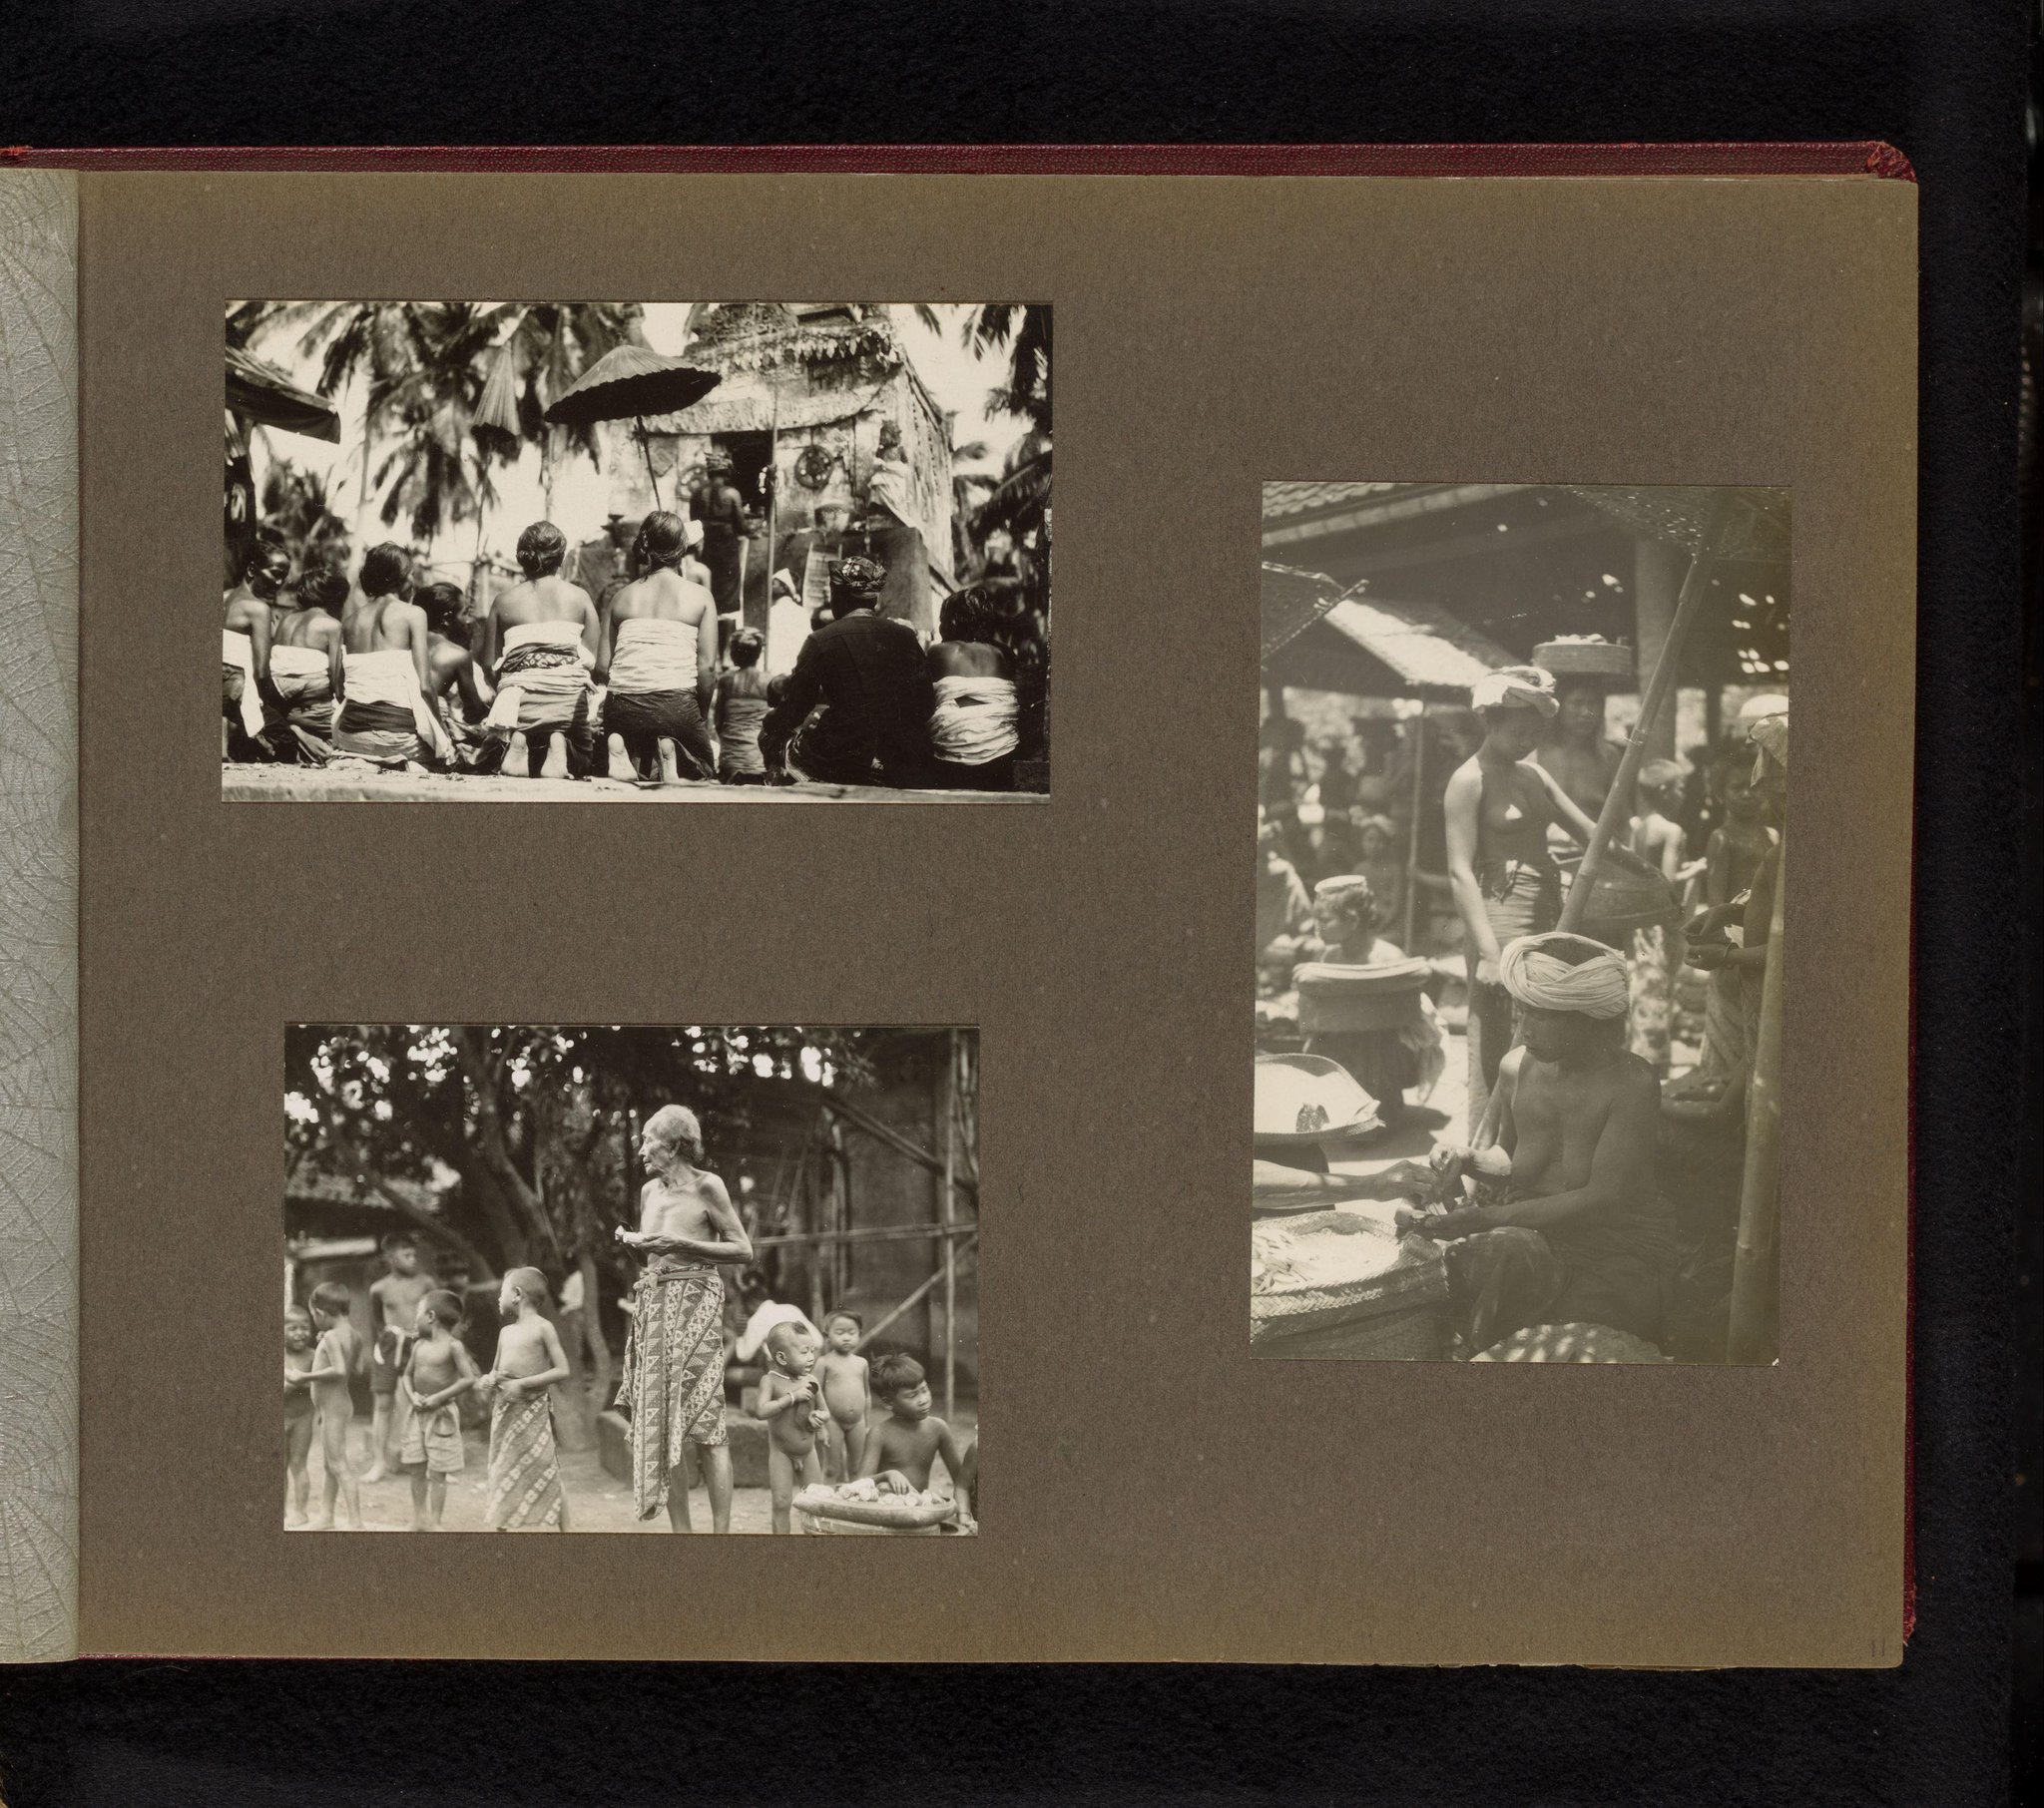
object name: photograph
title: Groep geknielde personen, Vrouwen op een markt en Oudere man met jongens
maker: Anonymous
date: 1950-1960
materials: photographic support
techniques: gelatin silver print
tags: adult woman, boy (child between toddler and youth), historical persons, old man, market, kneeling on both knees, dutch east indies, the